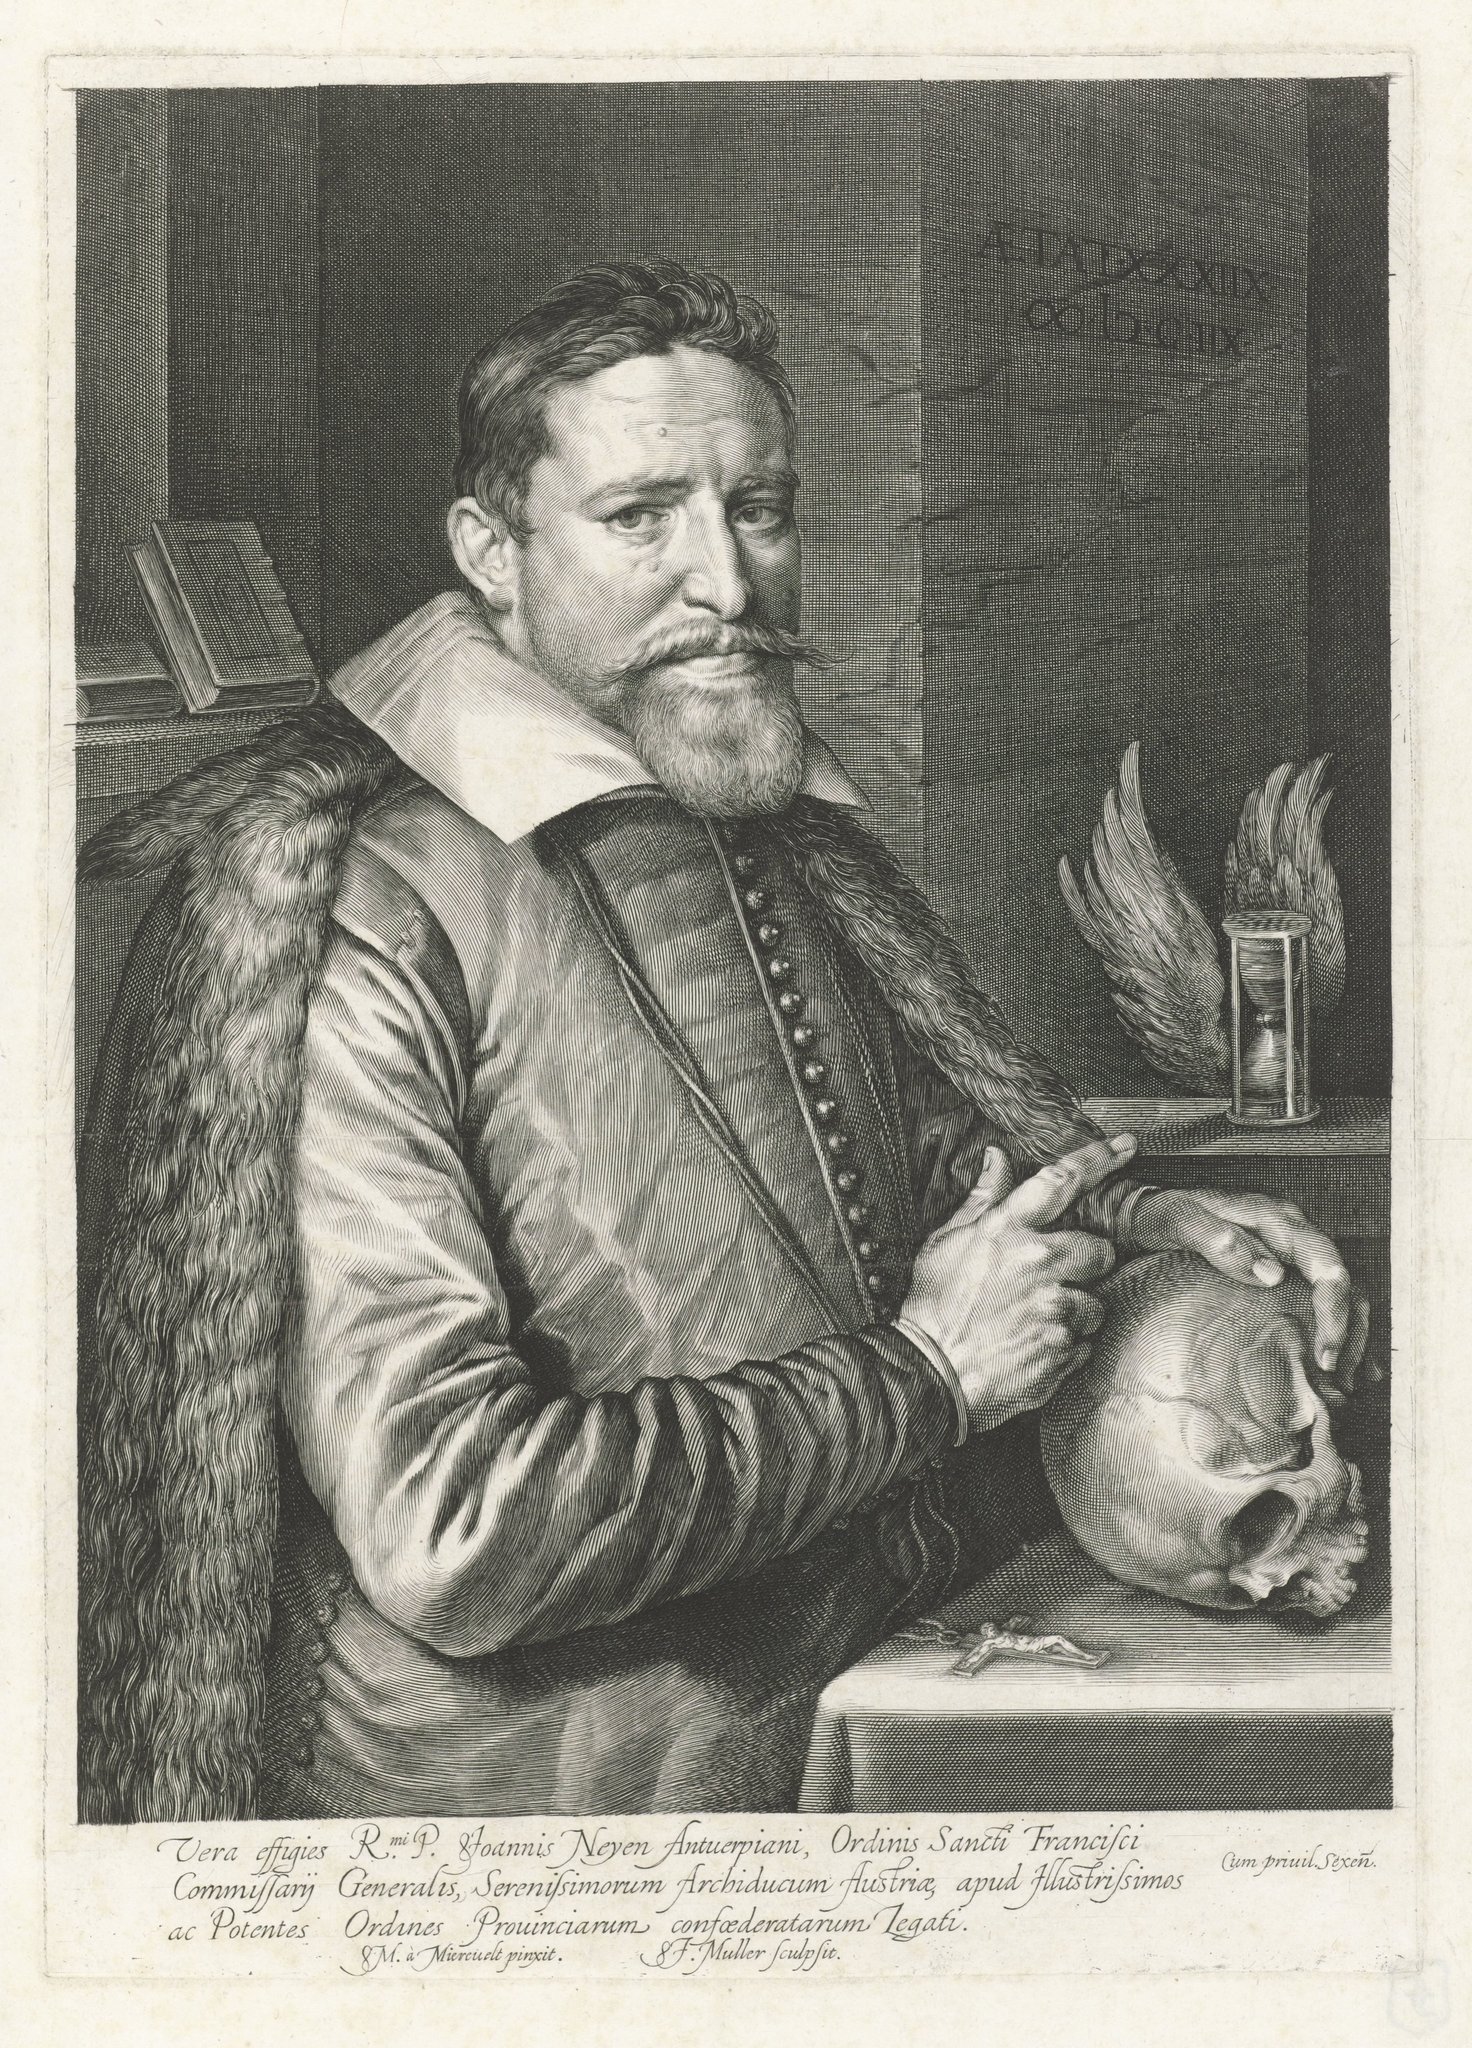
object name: print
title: Portret van Jan Neyen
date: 1608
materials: paper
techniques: engraving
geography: amsterdam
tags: antwerp, spain, hourglass, death's head, skull (symbol of death)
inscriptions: collector's mark: Lugt 963, collector's mark: Lugt 2228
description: Portret van Jan Neyen, minderbroeder en onderhandelaar met de Staten Generaal over het Twaalfjarig Bestand. Hij laat een hand rusten op een schedel en wijst met de ander naar een gevleugelde zandloper. Op tafel ligt een crucifix.